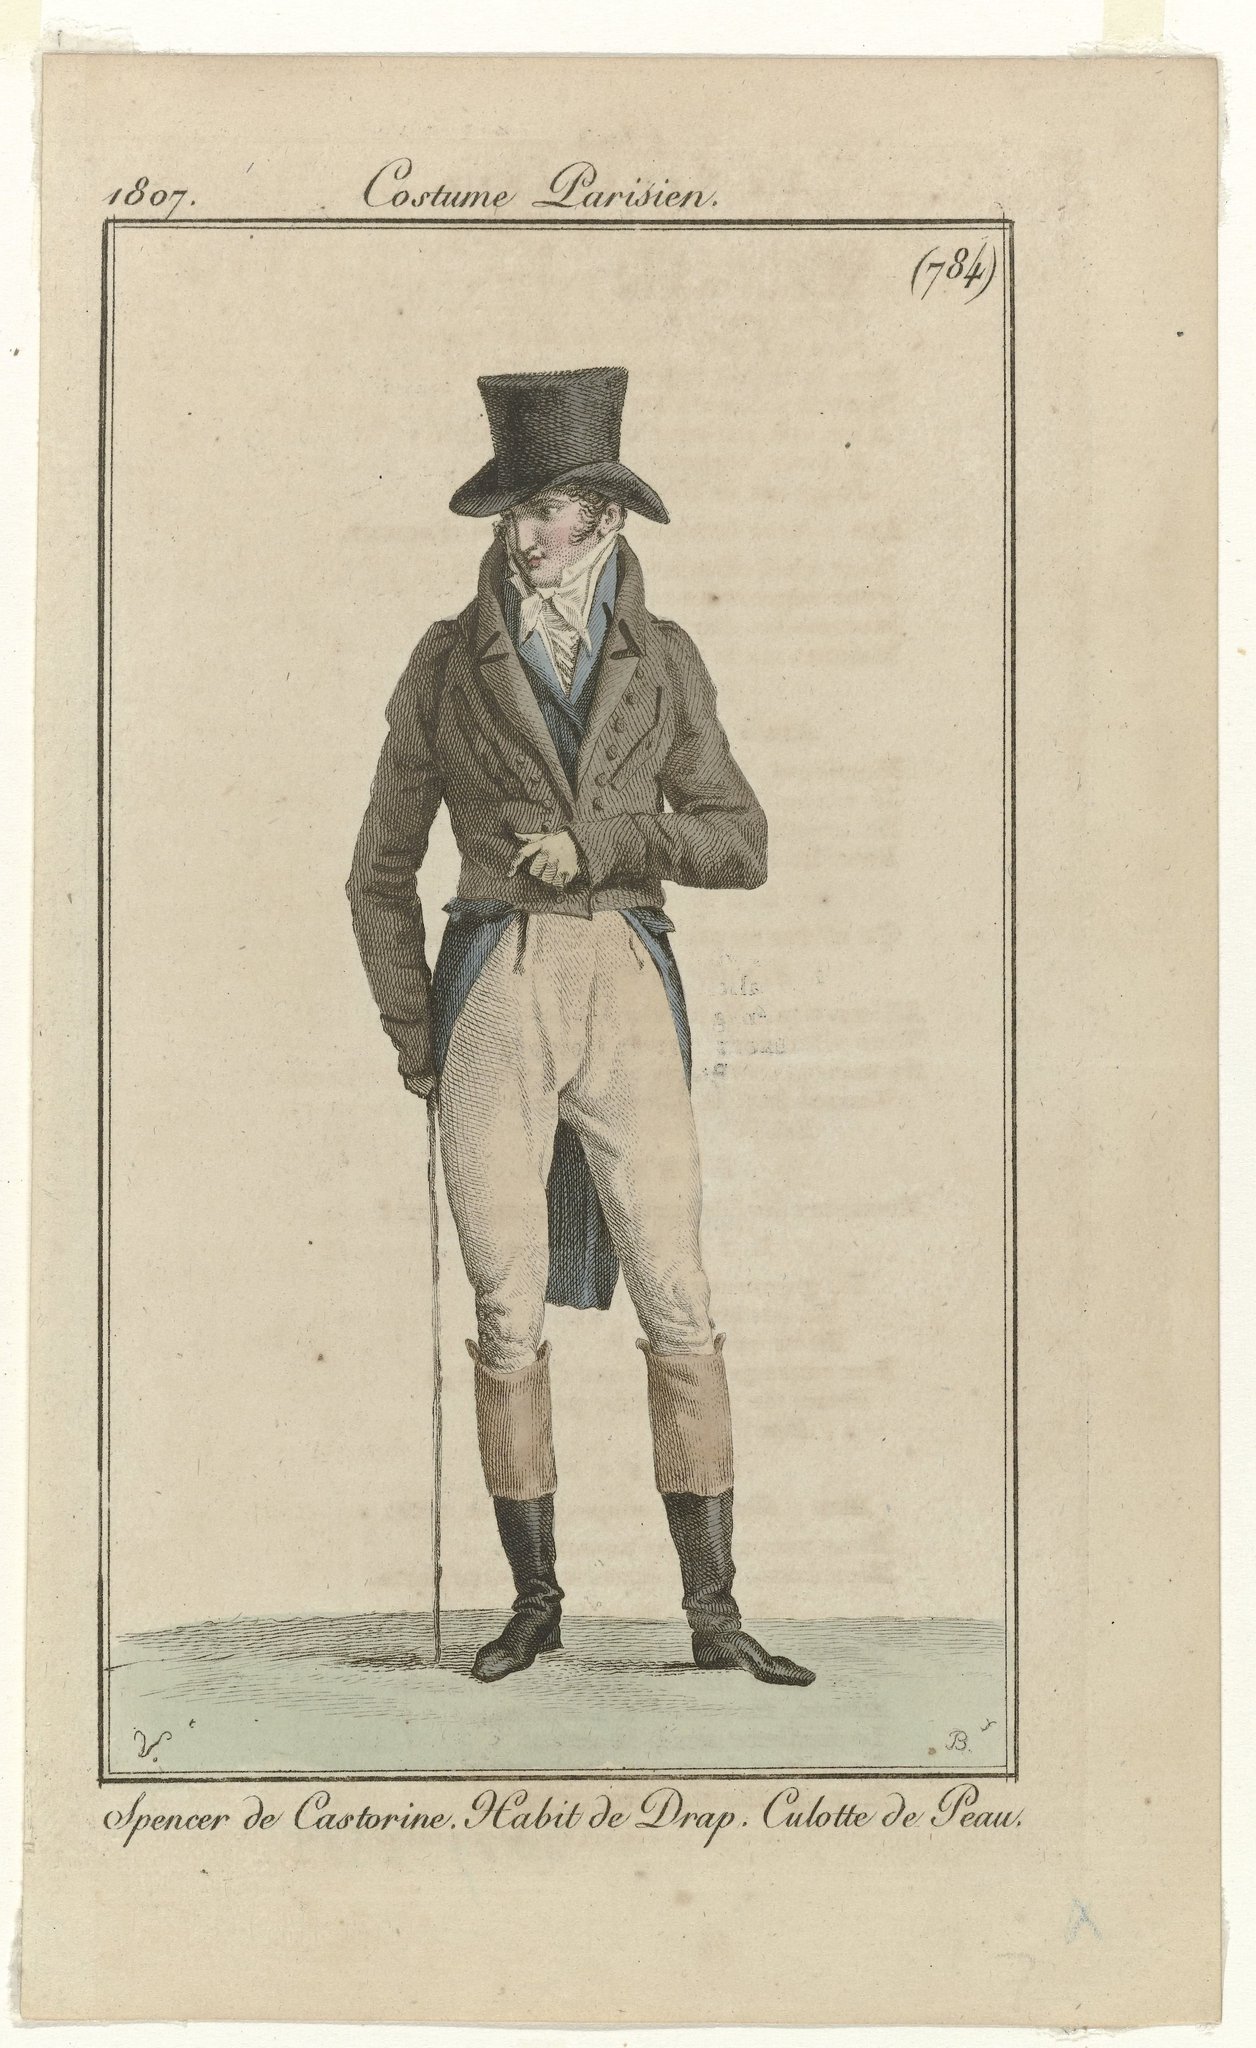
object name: fashion print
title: Journal des Dames et des Modes, Costume Parisien, 5 février 1807, (784): Spencer de Castorin (...)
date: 1807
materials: paper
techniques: engraving, hand coloring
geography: paris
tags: clothing for the upper part of the body (with name) (+ men's clothes), neck-gear ~ clothing (cravat) (+ men's clothes), coat (+ men's clothes), clothing for the upper part of the body (spencer) (+ men's clothes), fashion plates, trousers, breeches, etc. (breeches) (+ men's clothes), gloves, mittens, etc. (+ men's clothes), walking-stick, staff, cane (+ men's clothes)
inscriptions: caption: ‘Spencer de Castorine. Habit de Drap. Culotte de Peau.’, title: ‘Costume Parisien.’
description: Staande man gekleed in een 'spencer de Castorine' op een 'habit' van laken. Kniebroek van leer. Hemd en cravate. Accessoires: hoge hoed, handschoenen, wandelstok, laarzen met contrasterende omslagen. De prent maakt deel uit van het modetijdschrift Journal des Dames et des Modes, uitgegeven door Pierre de la Mésangère, Parijs, 1797-1839.